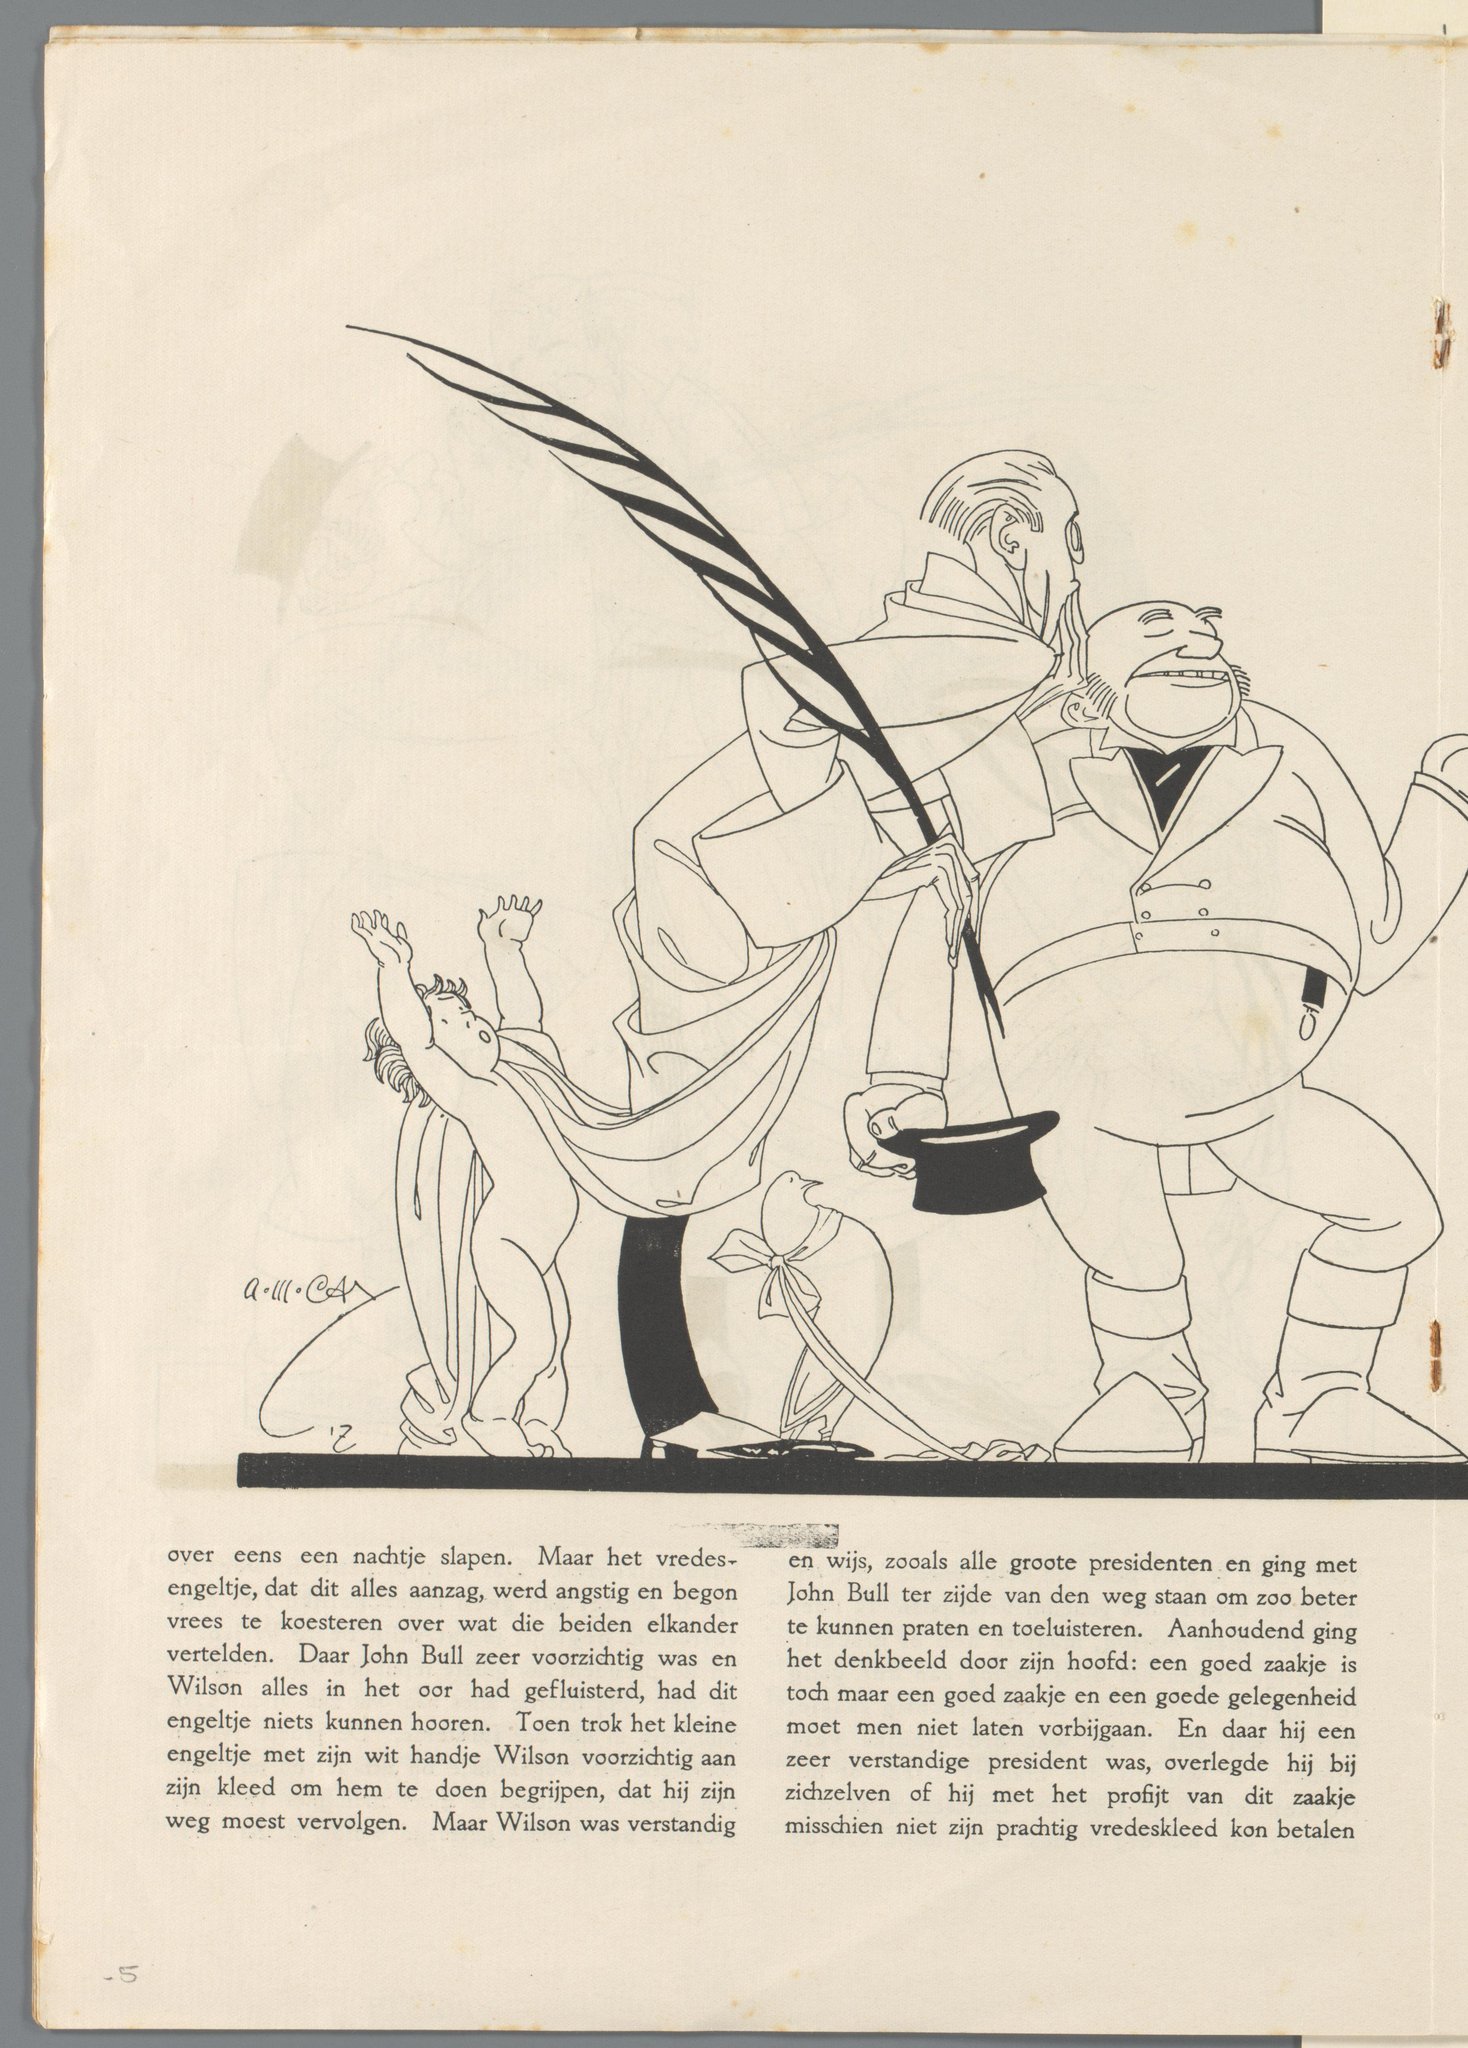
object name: photomechanical print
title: John Bull toont Woodrow Wilson zijn vele vrienden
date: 1917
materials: paper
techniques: printing block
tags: personifications of countries, nations, states, districts, etc., president ~ head of republic, political caricatures and satires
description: Links Bull en Wilson, en rechts een aantal landen voorgesteld door personen. Deze prent maakt deel uit van een boek.